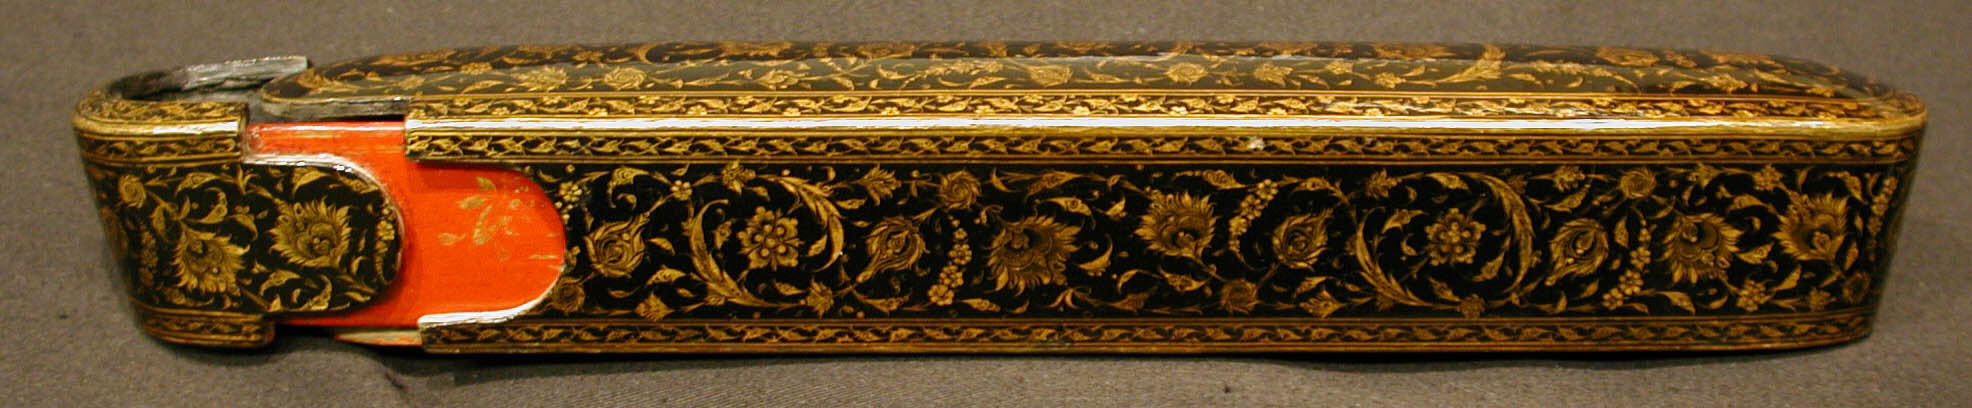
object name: pen box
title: Pen Box (Qalamdan)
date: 1801-1900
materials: paper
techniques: gilding, lacquer, painting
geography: iran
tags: flowers